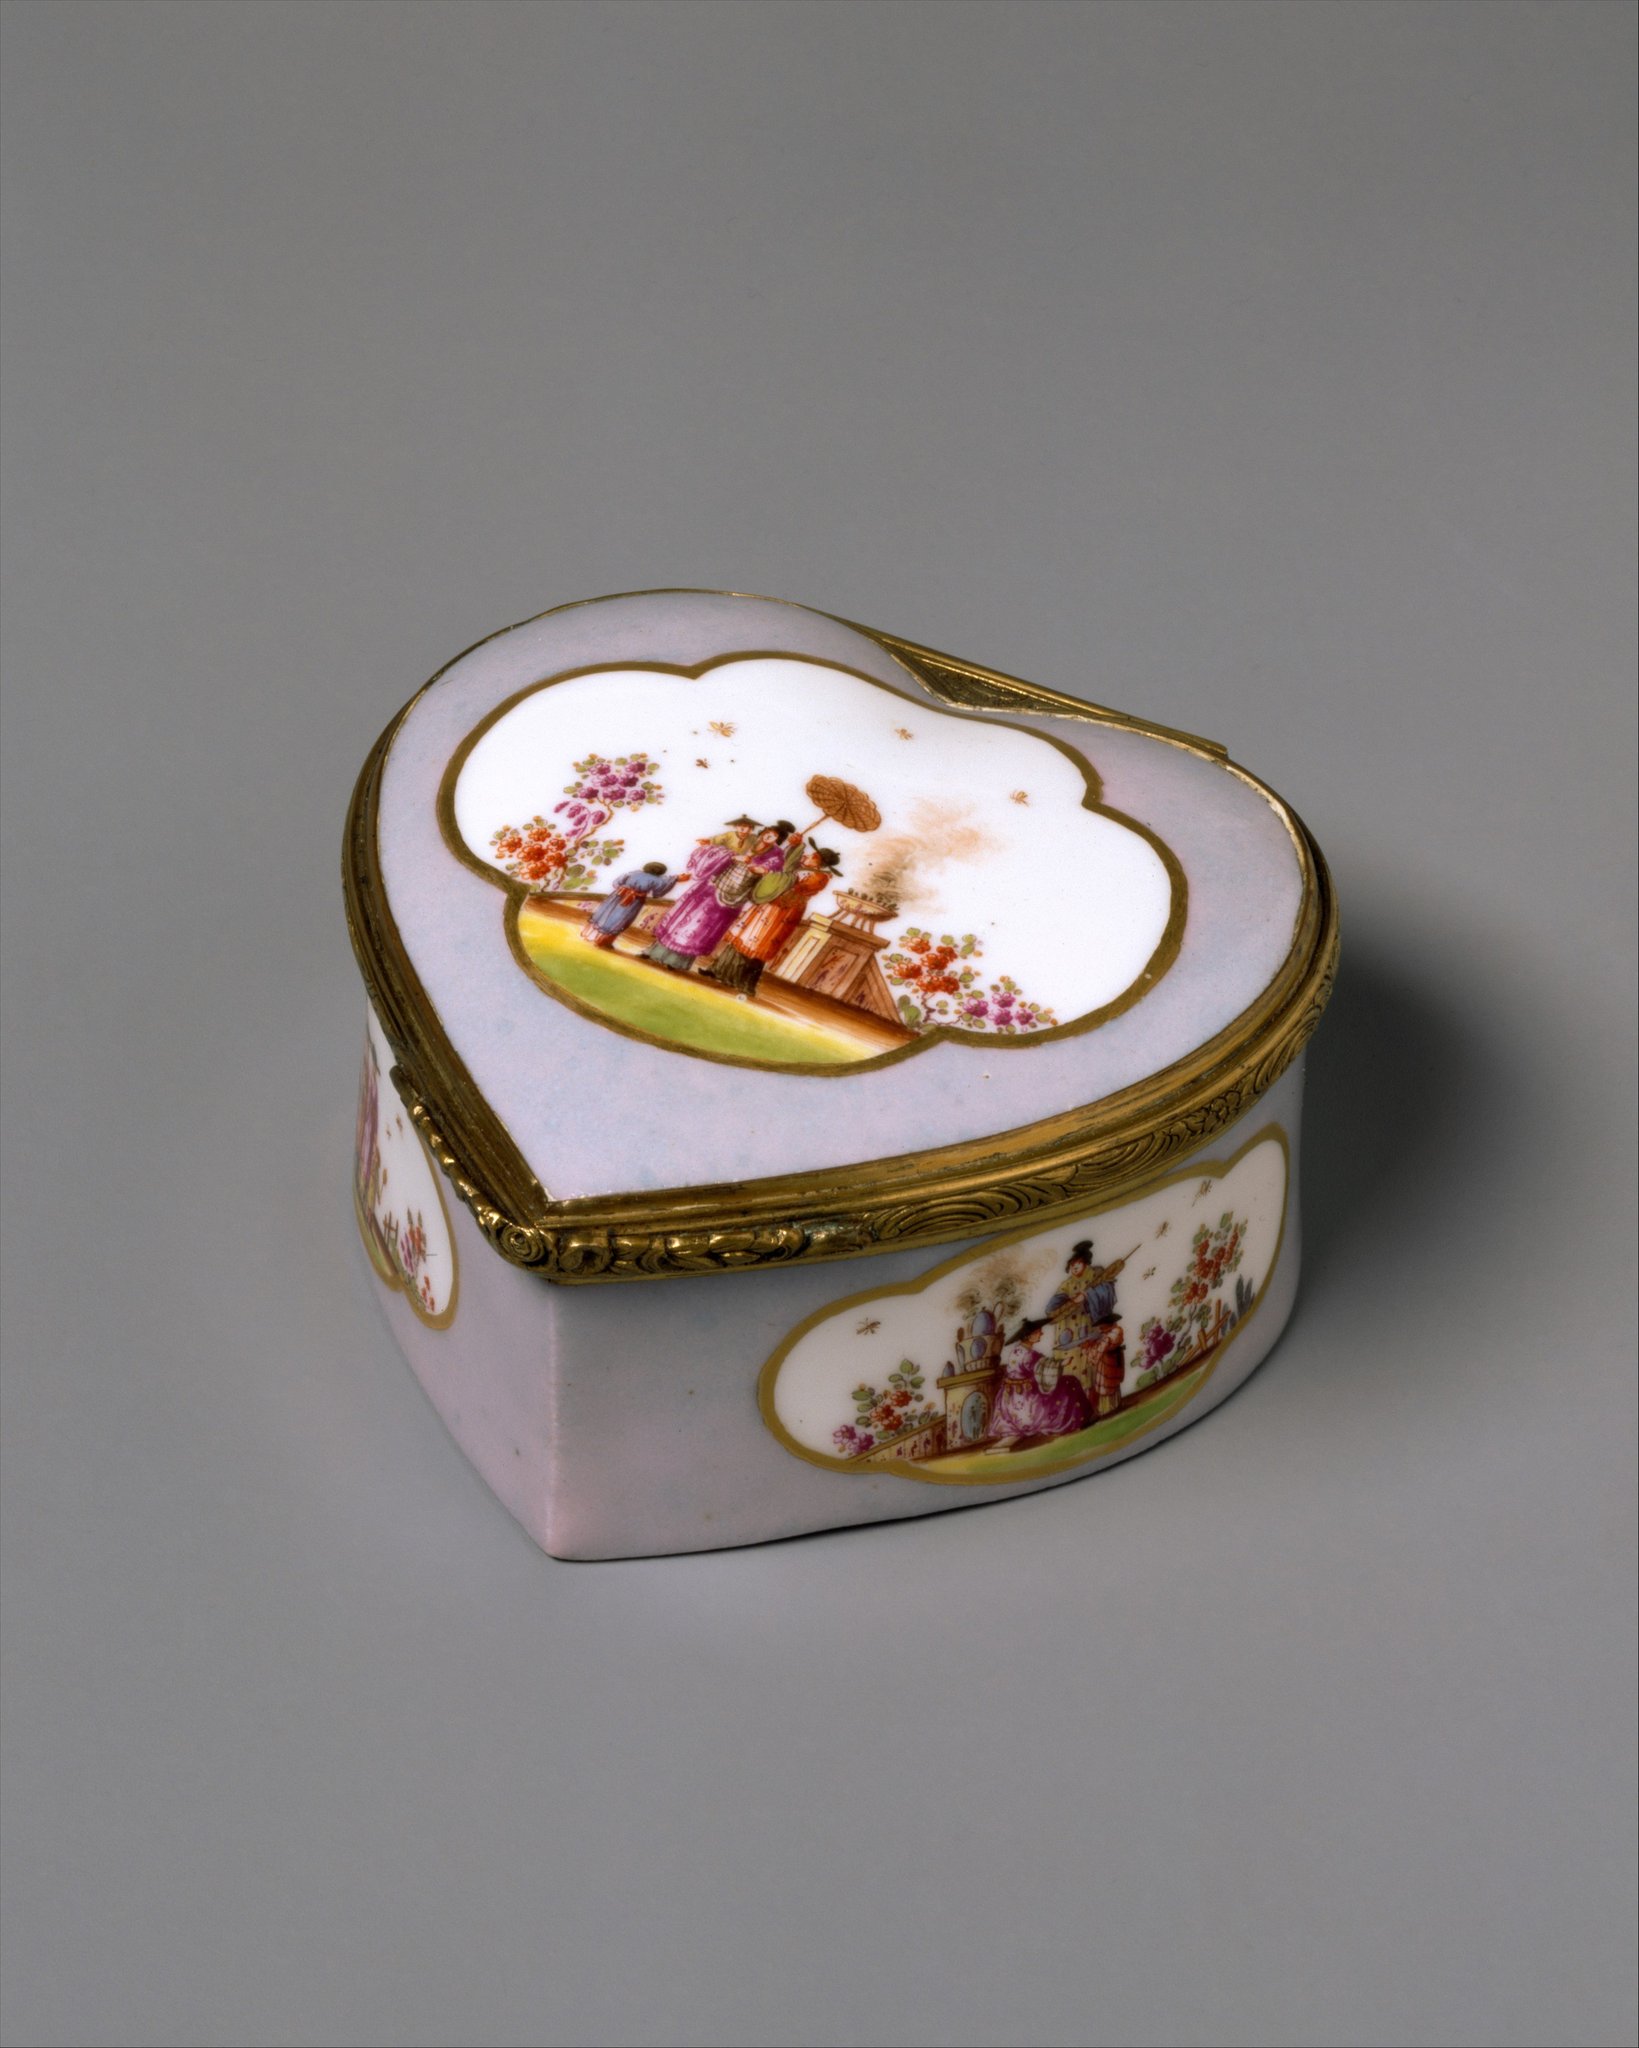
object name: snuffbox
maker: meissen manufactory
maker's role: manufactory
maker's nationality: german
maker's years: 1710-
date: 1730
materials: gilt bronze, hard paste porcelain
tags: human figures,chinoiserie